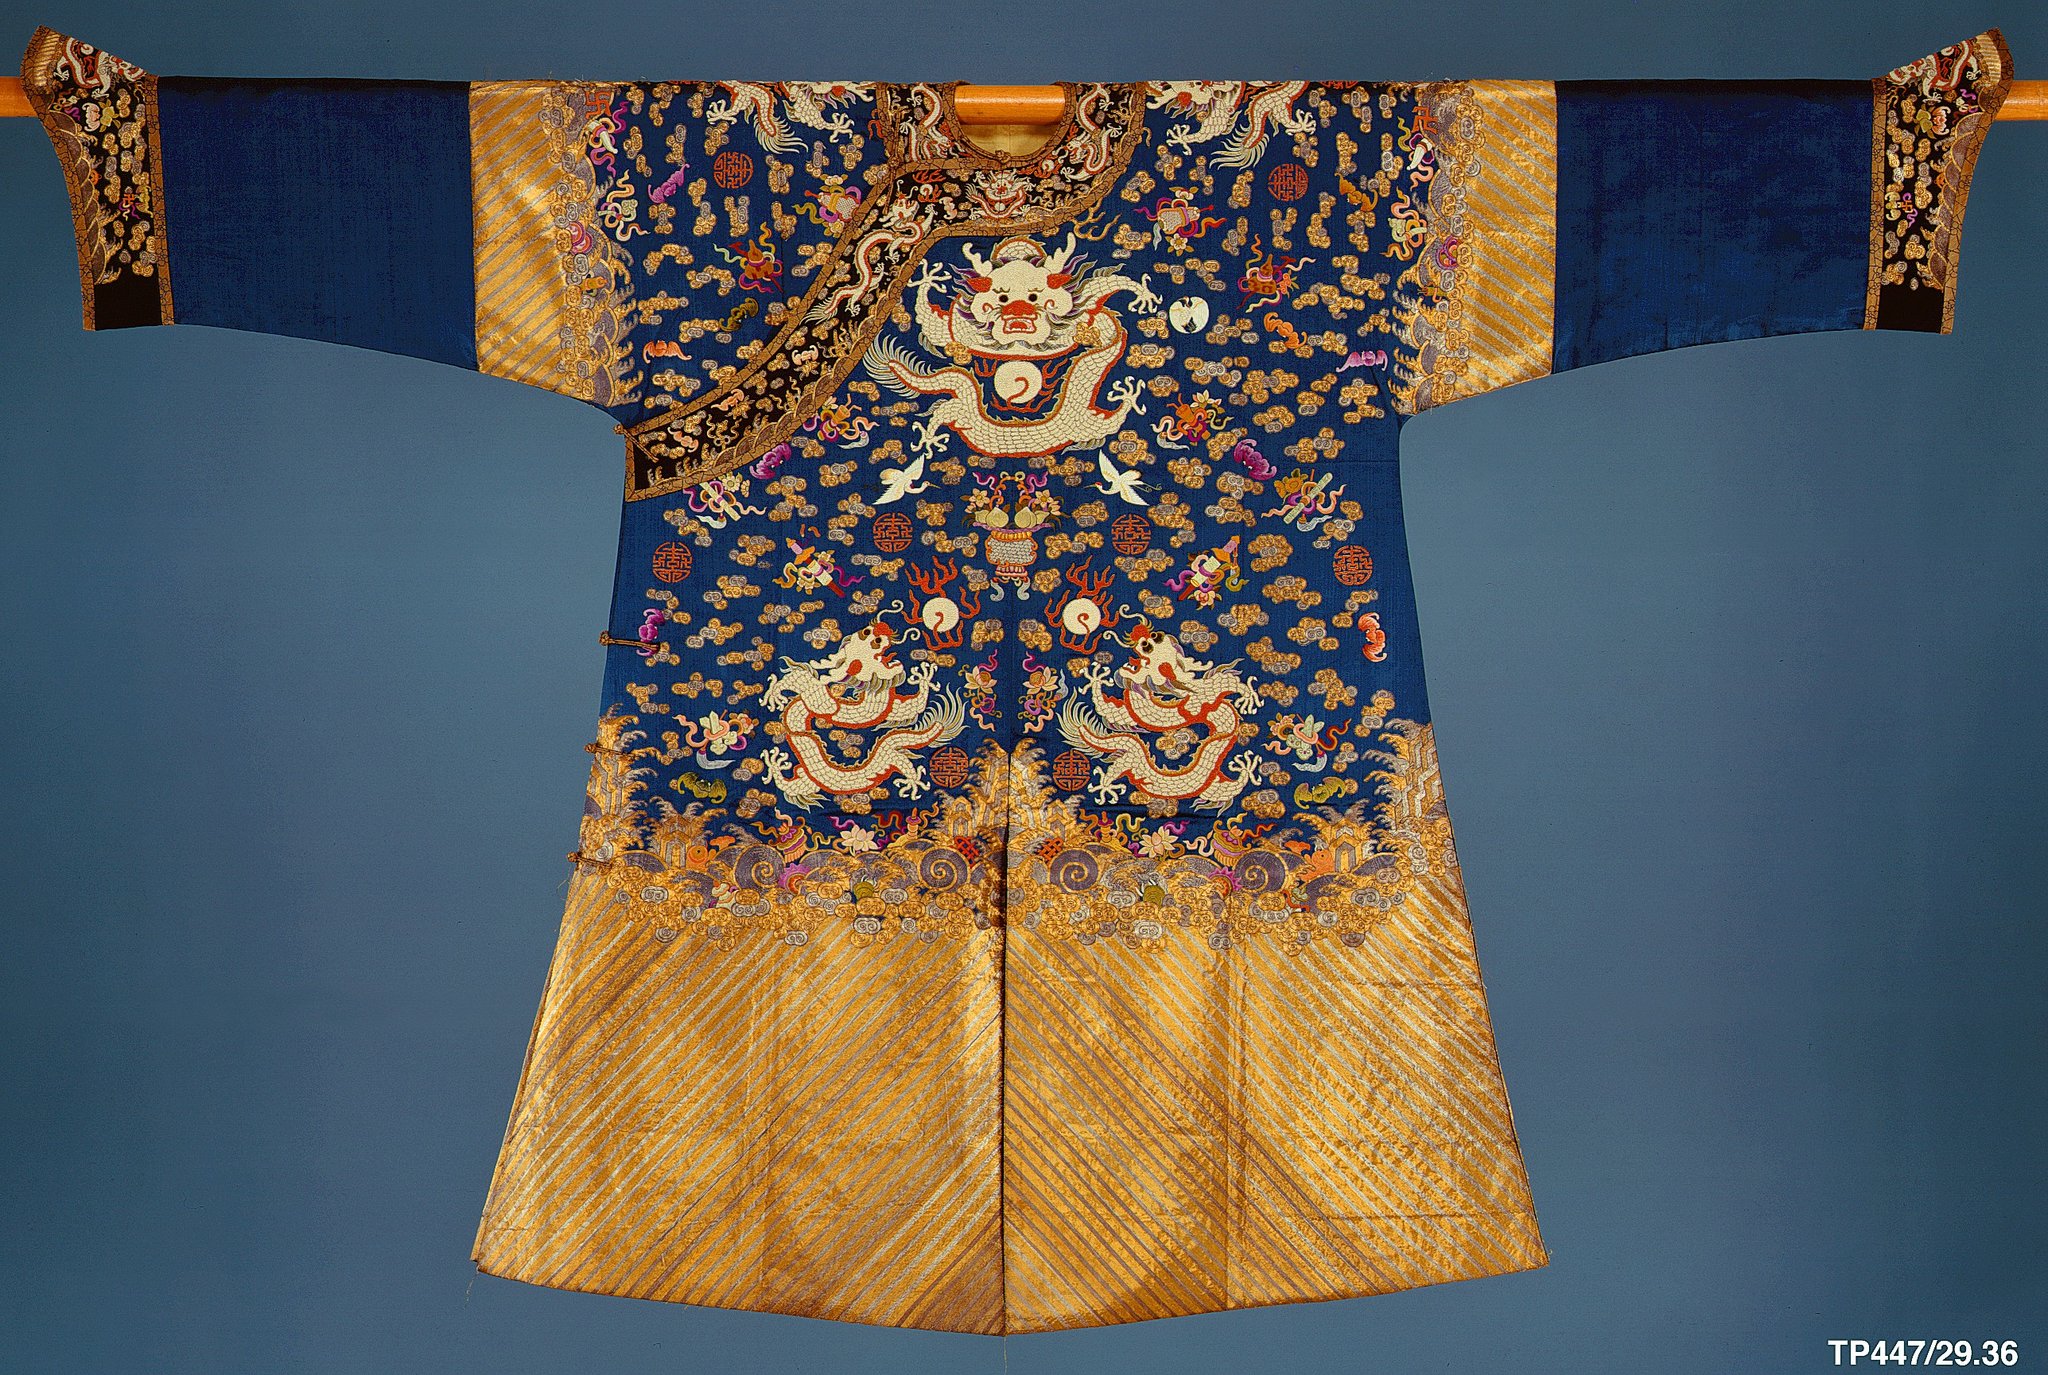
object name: robe, court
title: Embroidered Court Robe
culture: chinese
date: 1801-1900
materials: coral, metal thread, pearl, silk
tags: bats,cranes,dragons,fish